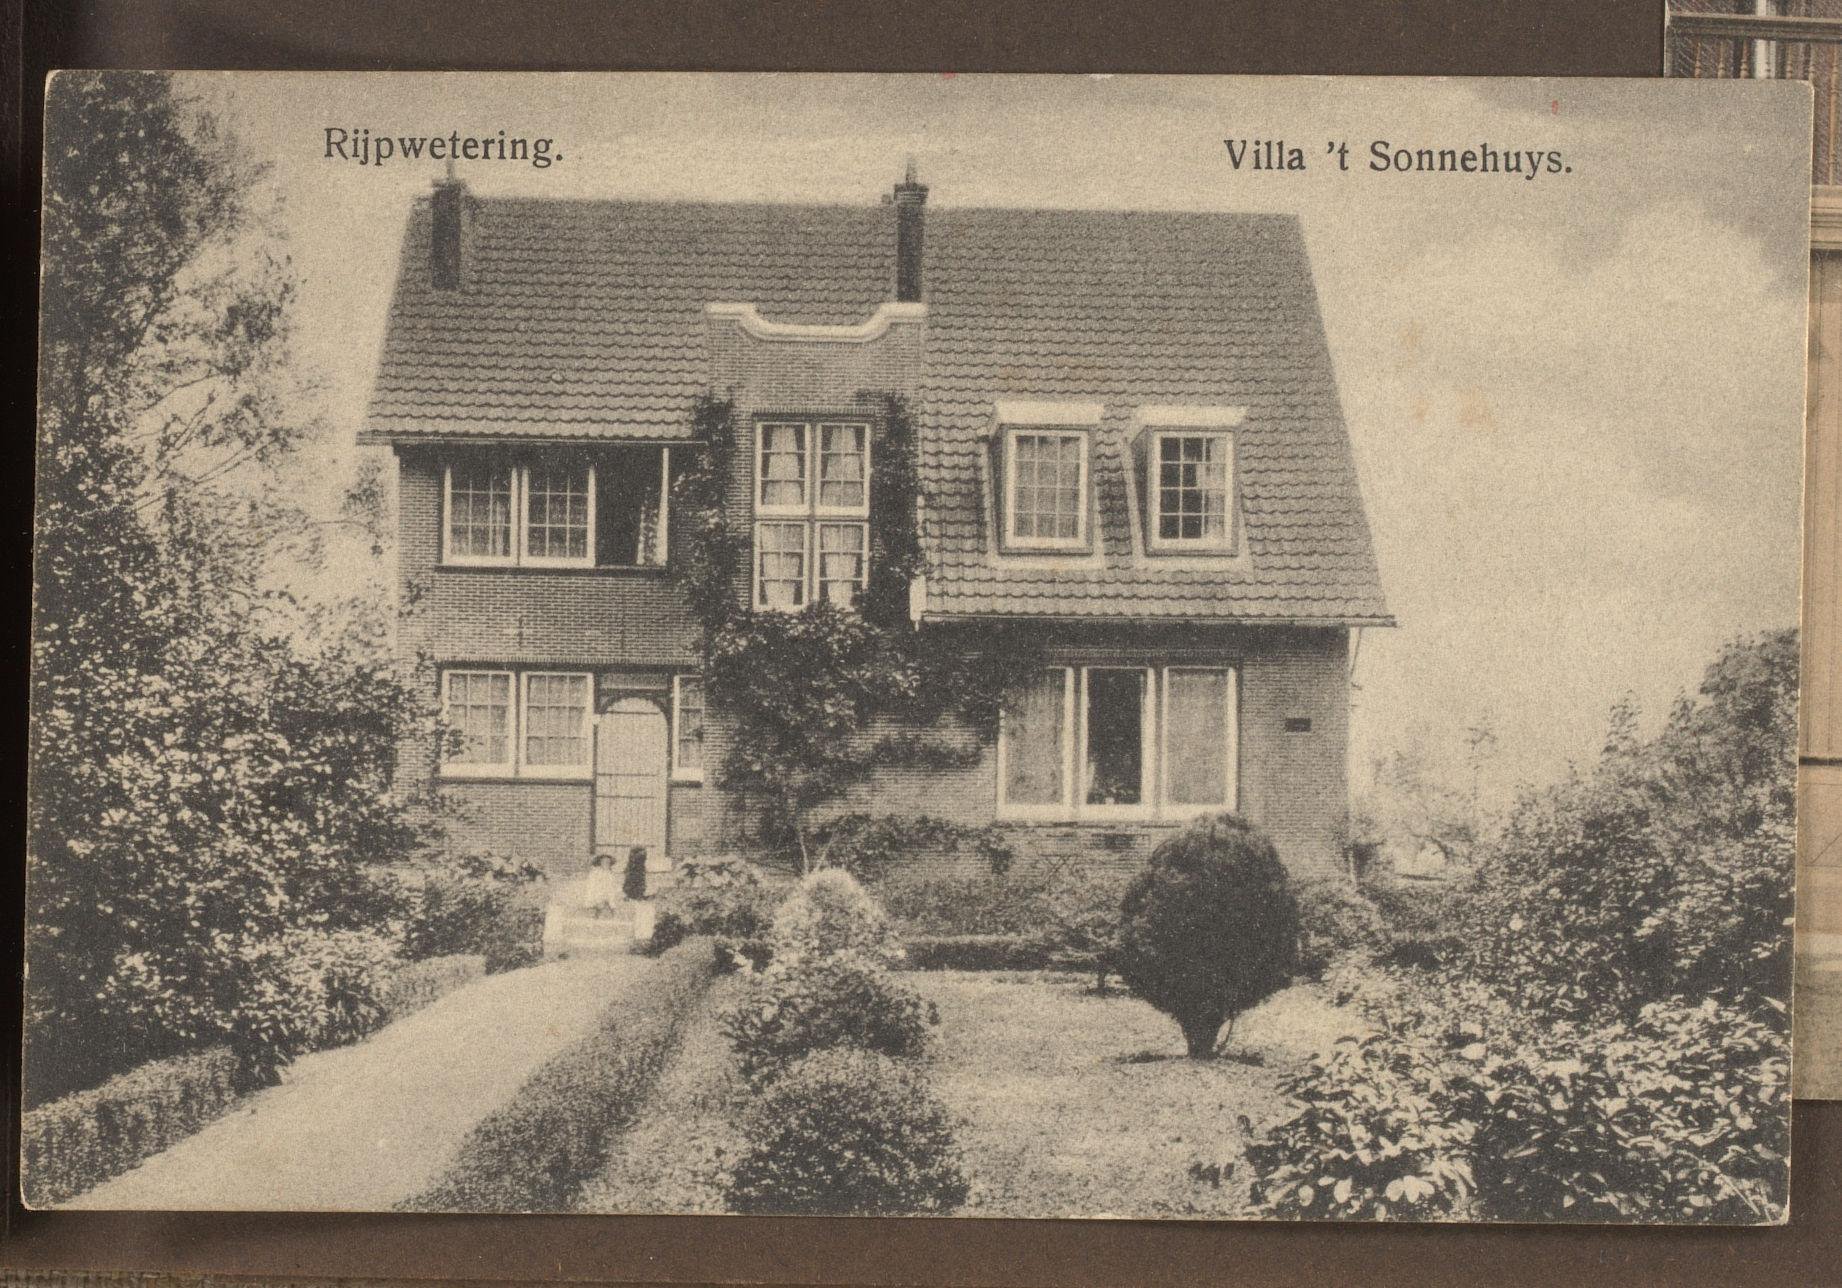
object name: photomechanical print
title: Villa 't Sonnehuys te Rijpwetering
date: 1904-1930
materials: cardboard, paper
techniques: photograph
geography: rijpwetering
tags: villa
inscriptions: postage stamp, stamp: ‘B. 15’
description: Deze prentbriefkaart zit los in het album.